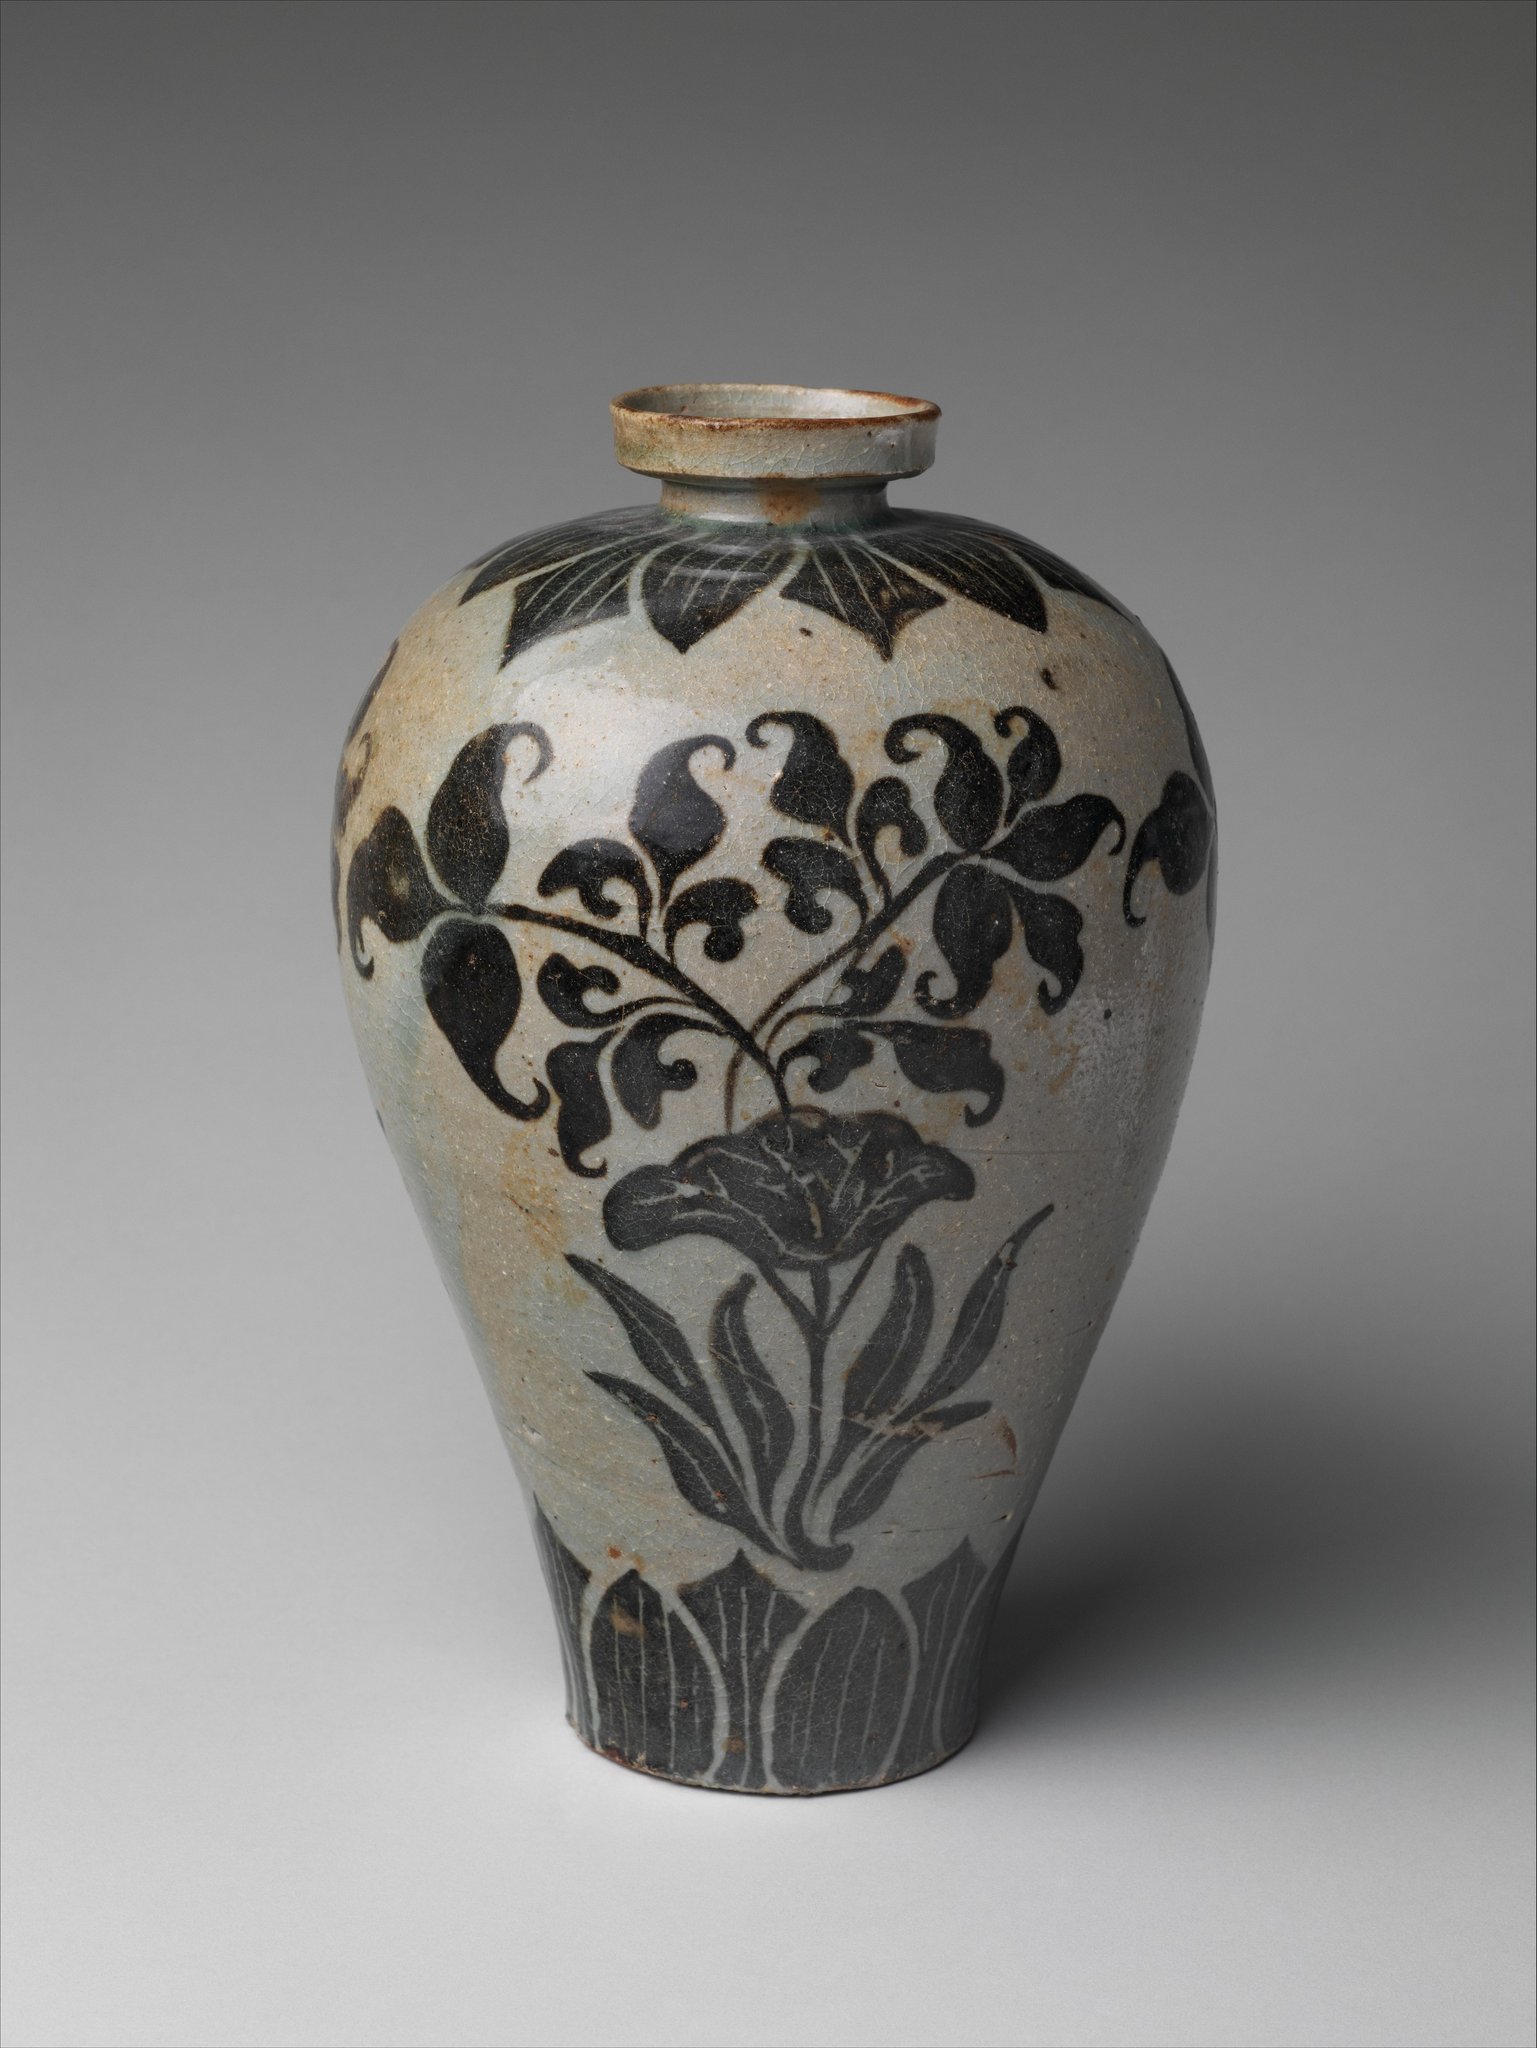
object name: vase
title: Maebyeong decorated with lotus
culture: korean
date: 1001-1100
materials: ceramic glaze, glaze, iron, stoneware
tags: lotuses